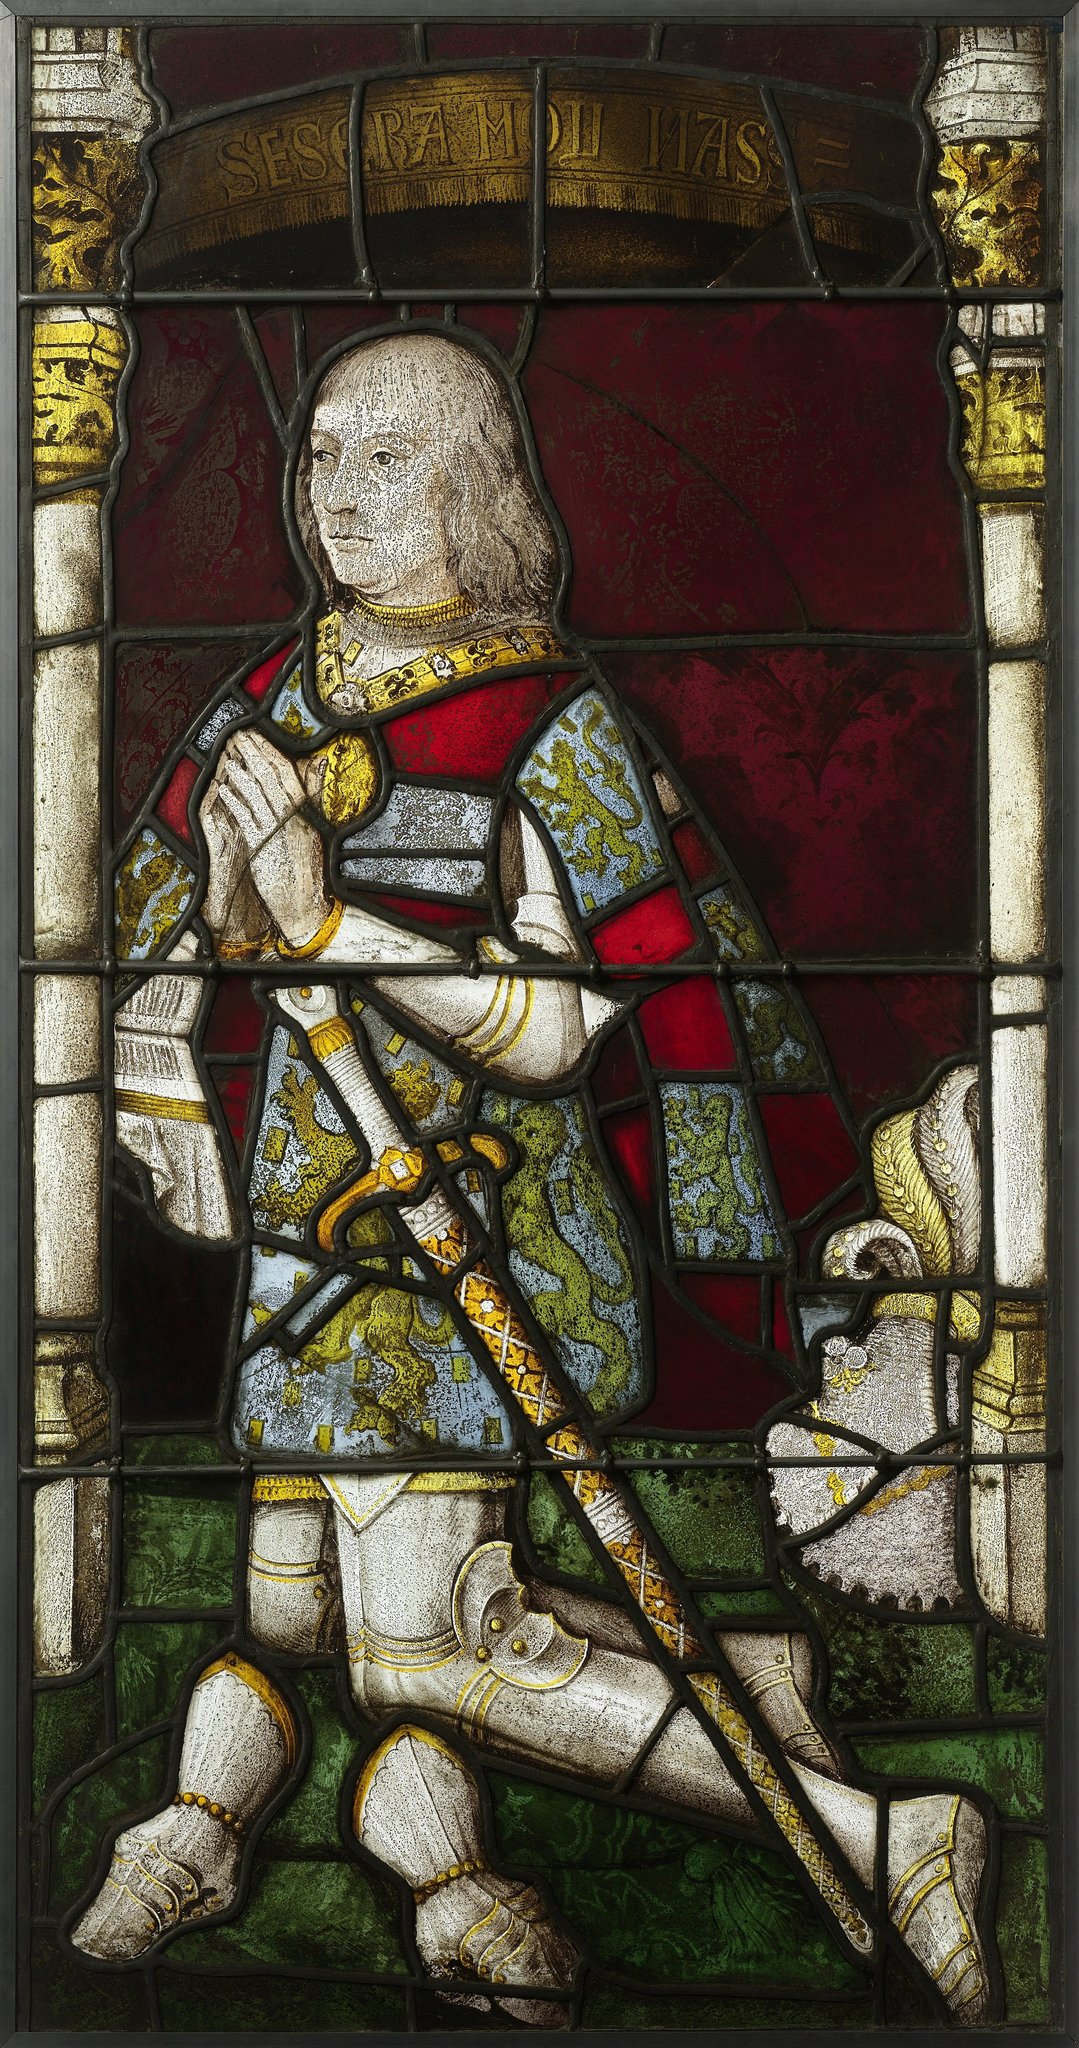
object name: light window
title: Portret van Engelbert II van Nassau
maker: nicolaes rombouts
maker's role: glasschilder, glazenier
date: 1500-1525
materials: glass, lead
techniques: leading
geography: brabant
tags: brussels, historical persons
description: Gebrandschilderd raam waarop geknielde man, draagt harnas met daarover wapenrok (met wapen van Nassau-Vianden), groot zwaard, orde (van het Gulden Vlies). Handen gevouwen, bij zijn knieën twee ijzeren handschoenen, vóór hem een boek op tafel, achter hem op de grond een helm. Aan weerszijden een zuil met basement en kapiteel met bladornamenten, boven hem een baldakijn met opschrift. Het glas is op drie plaatsen dwarsover verstevigd d.m.v. ronde ijzeren staven die door ogen, bevestigd aan het lood, lopen.